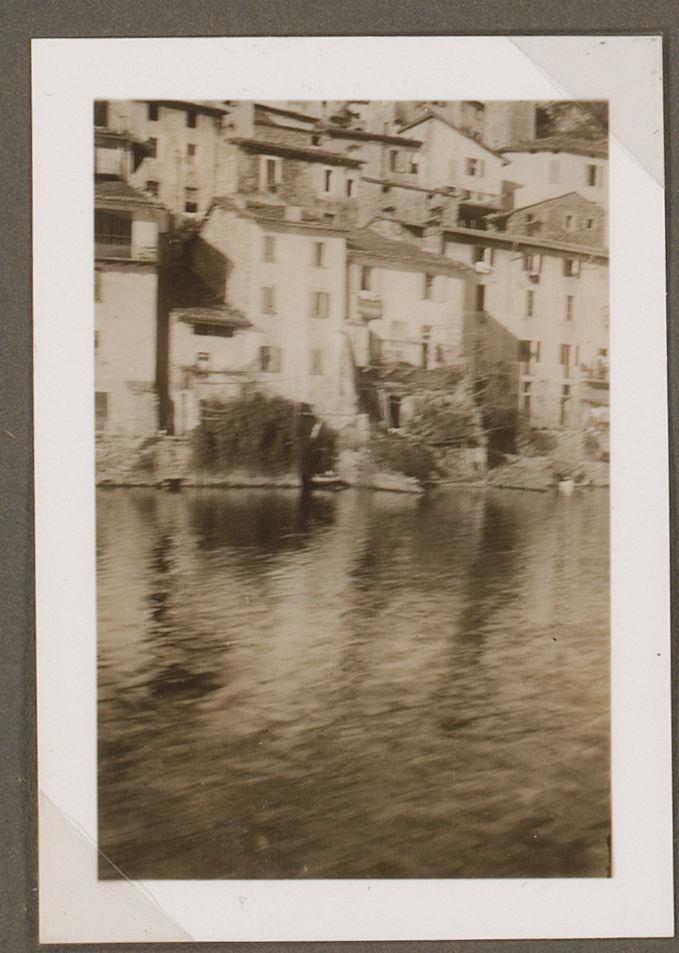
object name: photograph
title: Gandria vanaf de boot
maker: Anonymous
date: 1934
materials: photographic support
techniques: gelatin silver print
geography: lake lugano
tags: city-view in general; 'veduta', lake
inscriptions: number: ‘45’